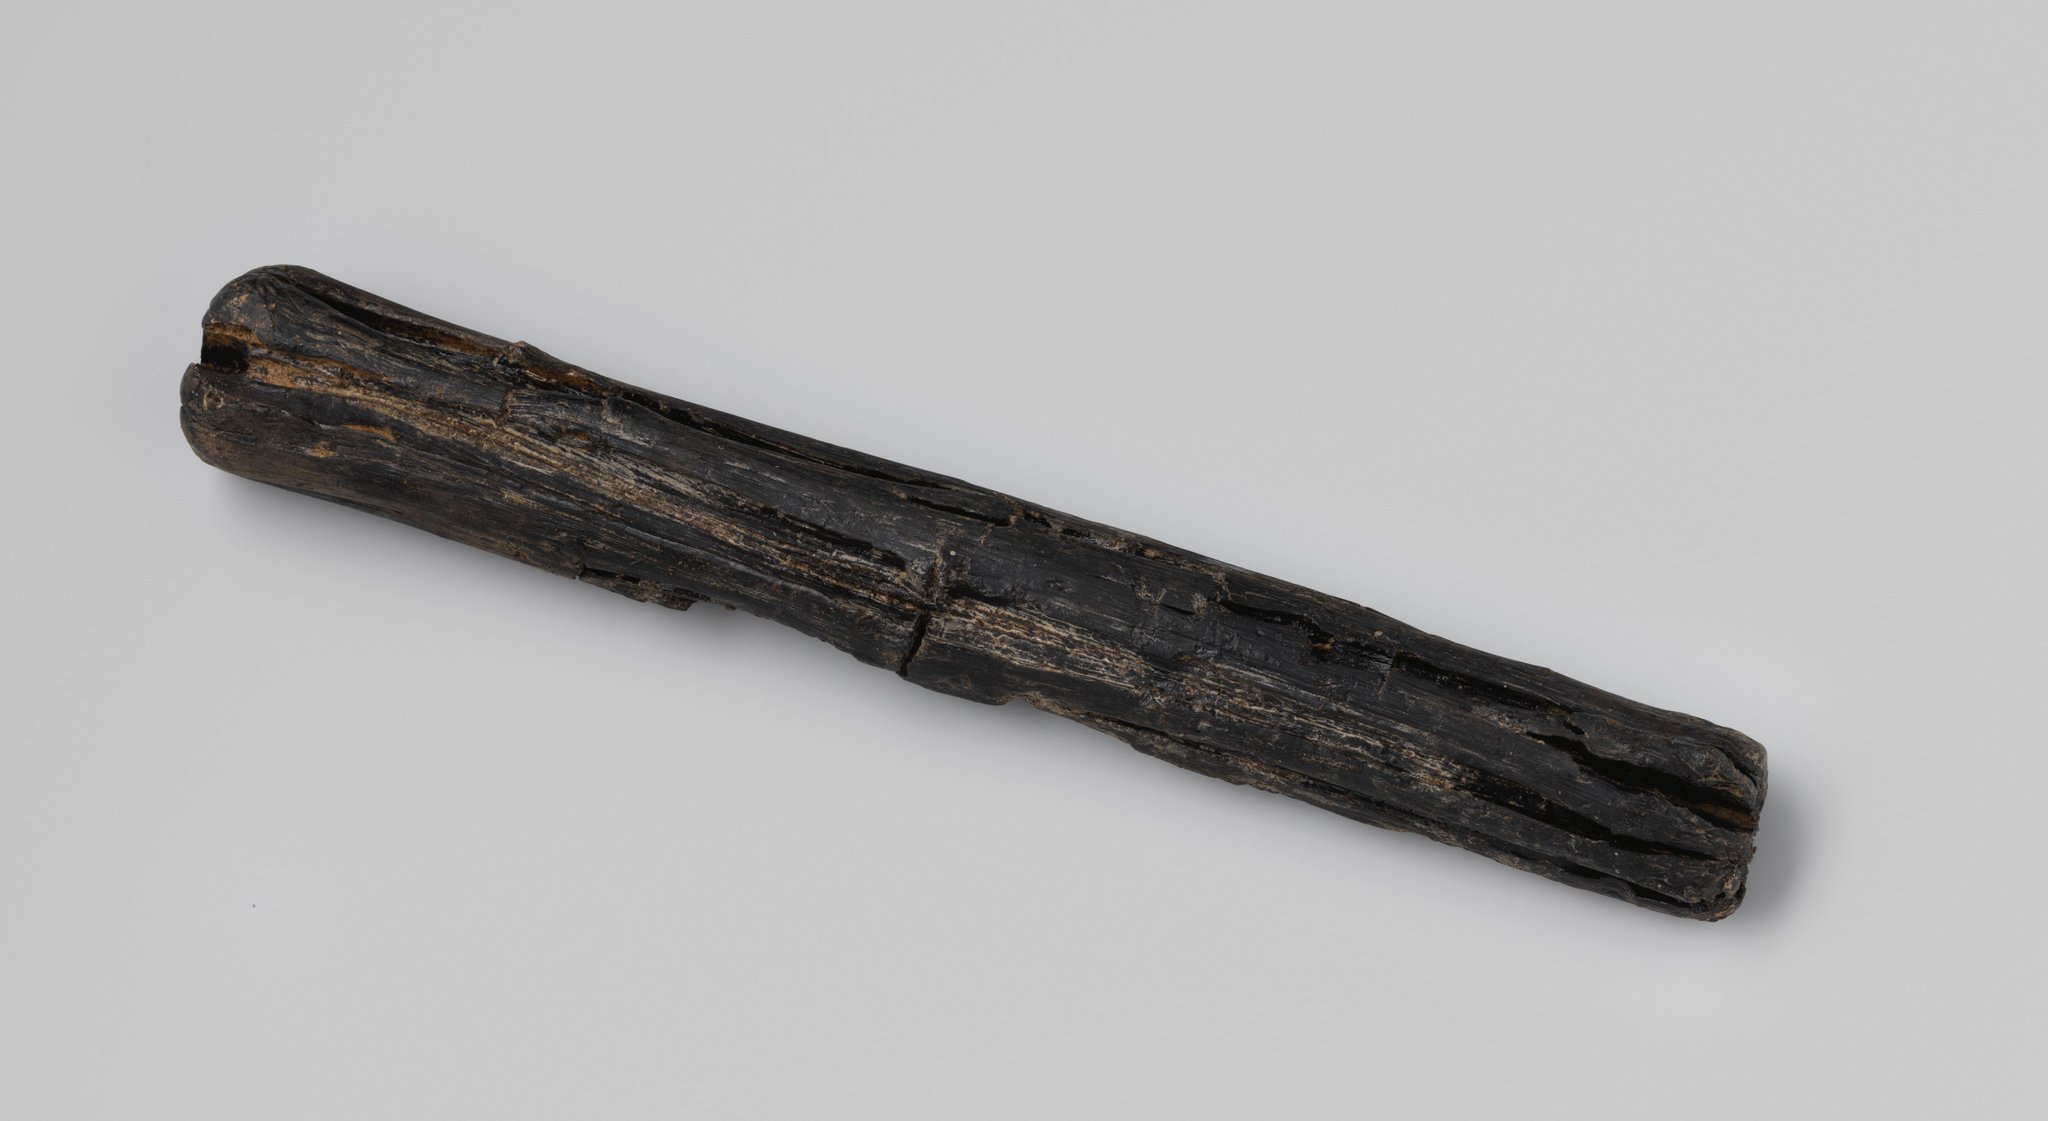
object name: fragment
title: Fragment of onderdeel uit het wrak van de Oost-Indiëvaarder Hollandia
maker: Anonymous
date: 1743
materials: wood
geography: netherlands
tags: verenigde oostindische compagnie, hollandia (schip), annet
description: Het VOC-schip De Hollandia is op de uitreis naar Indië vergaan op 13 juli 1743 nabij Bishop Rock, Scilly Eilanden.